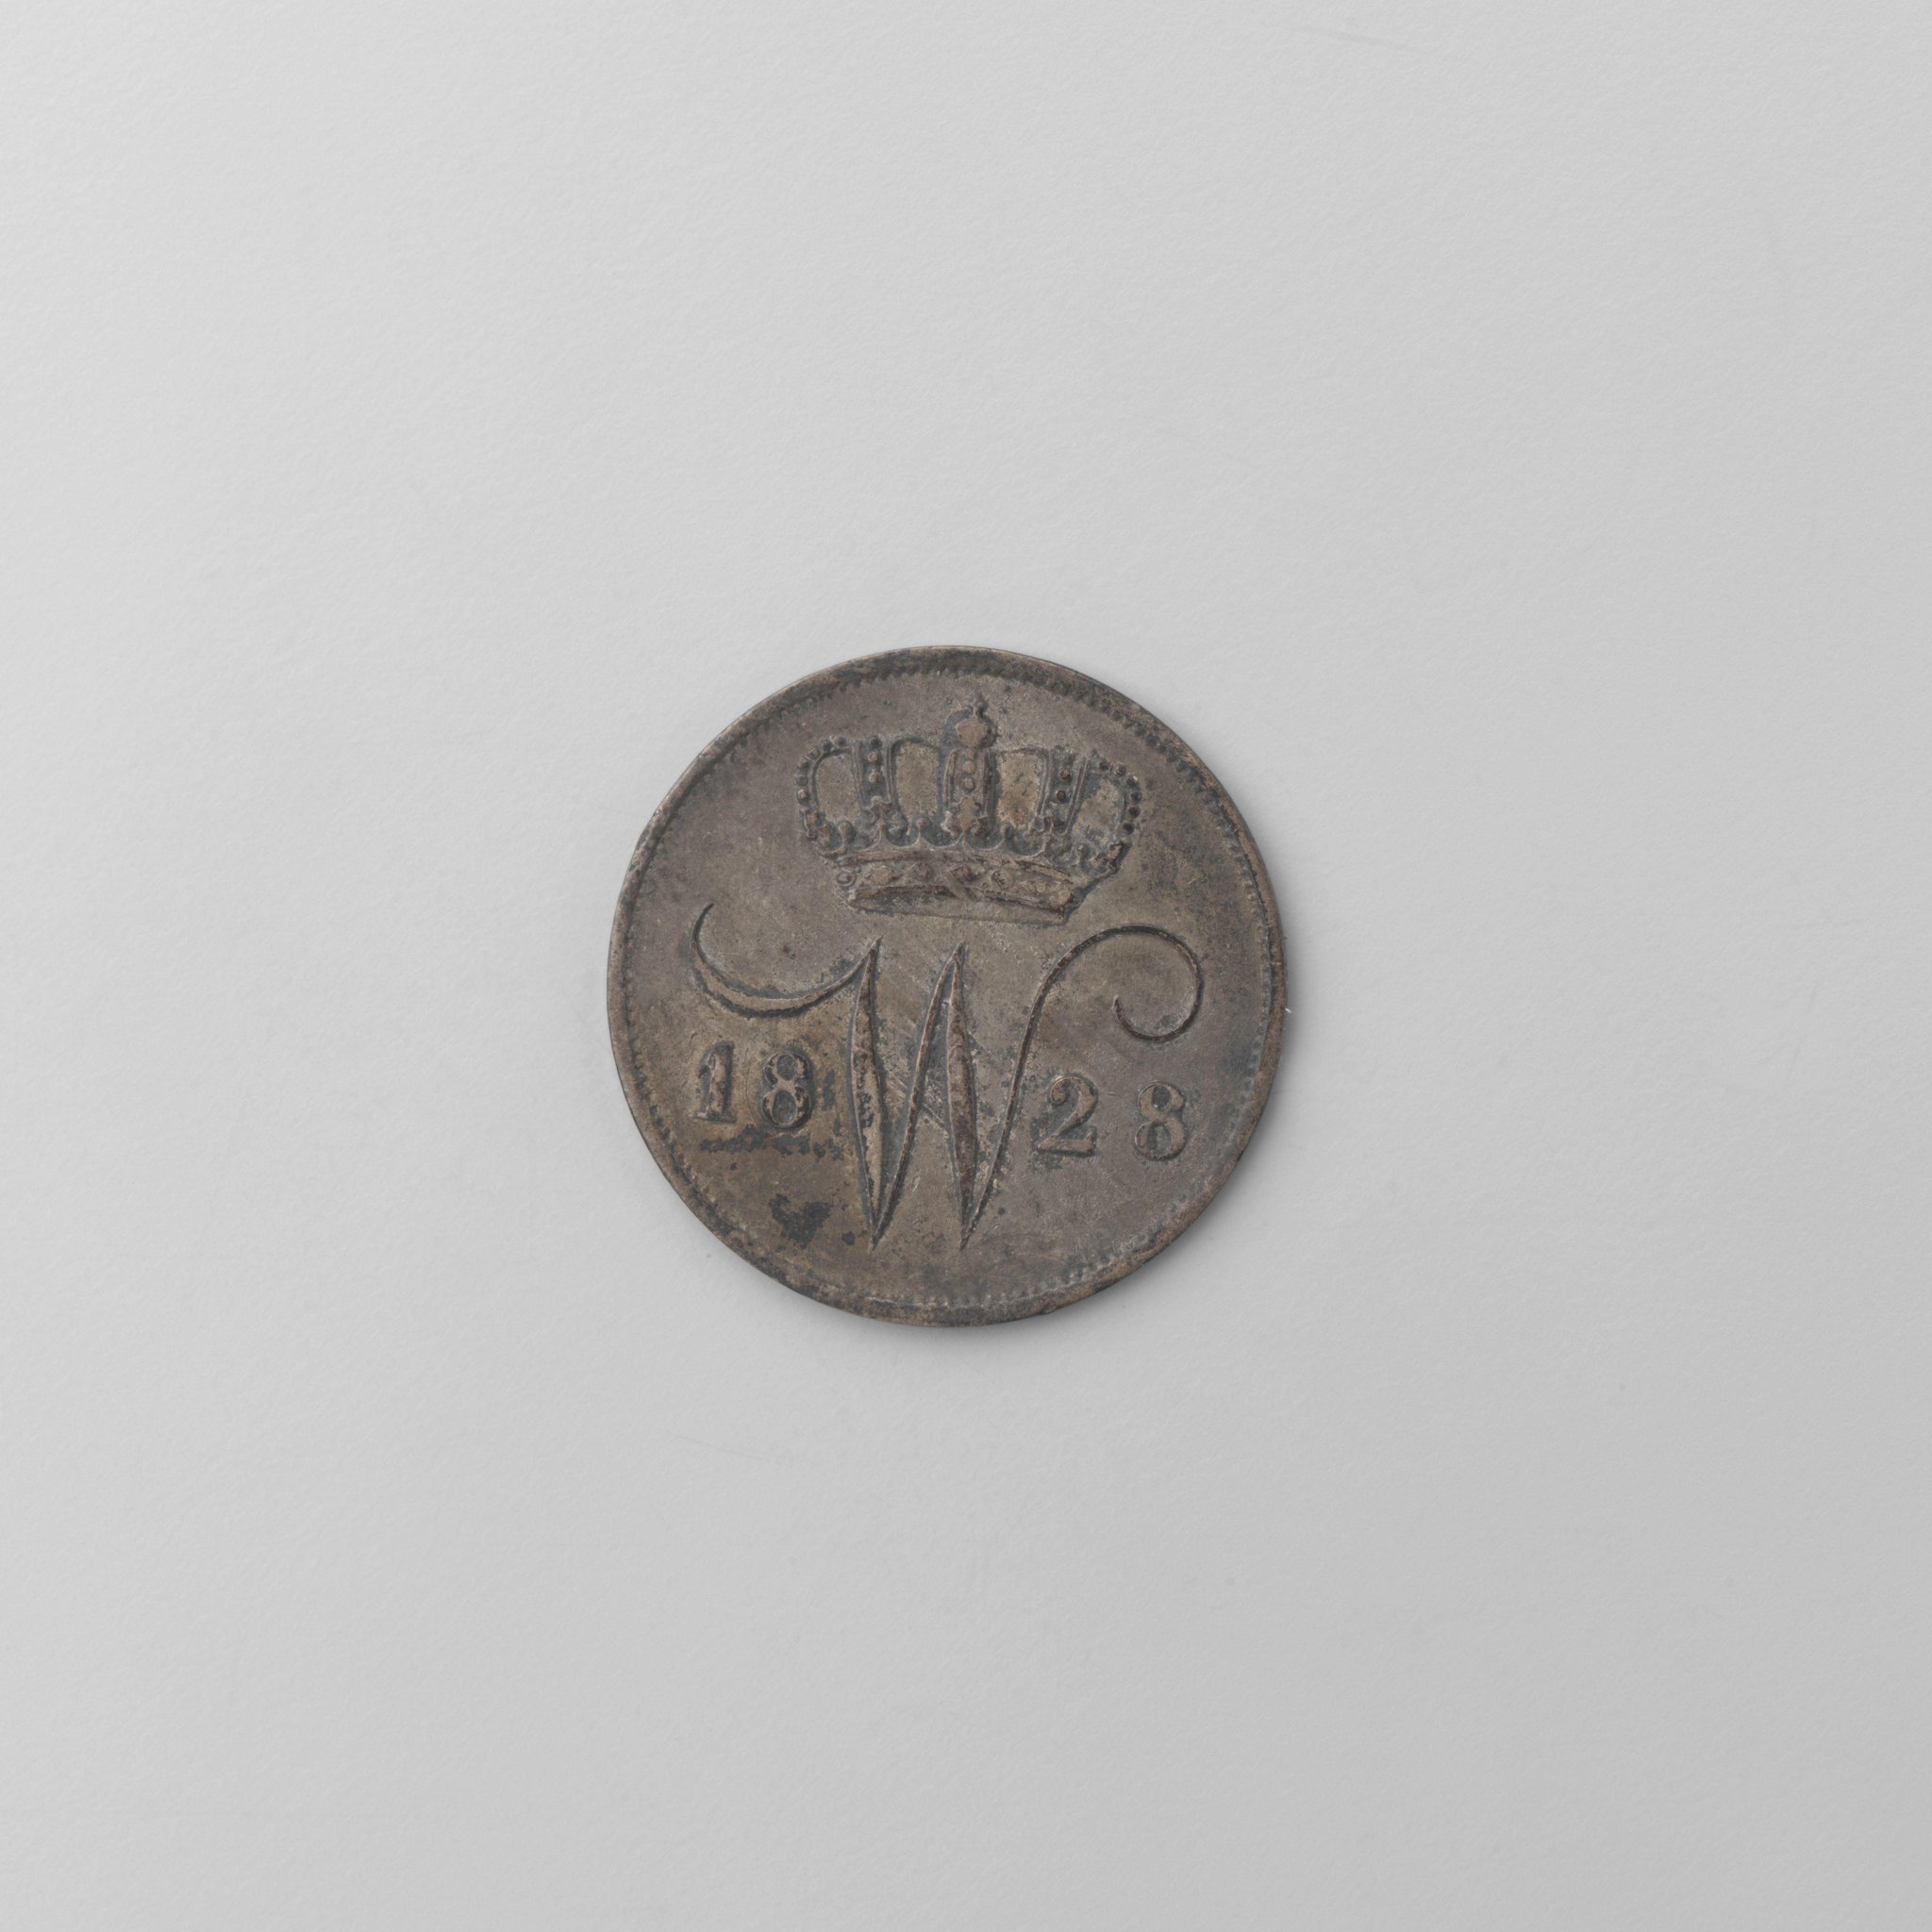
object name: tien cent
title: Nederlandse 10 cent, 1828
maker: william i of the netherlands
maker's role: koning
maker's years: 1772-1843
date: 1828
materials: silver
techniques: striking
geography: utrecht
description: Zilveren munt. Voorzijde: tussen jaartal gekroonde cursieve letter W. Keerzijde: tussen waarde-aanduiding 10 C. gekroond rijkswapenschild. Gladde rand.